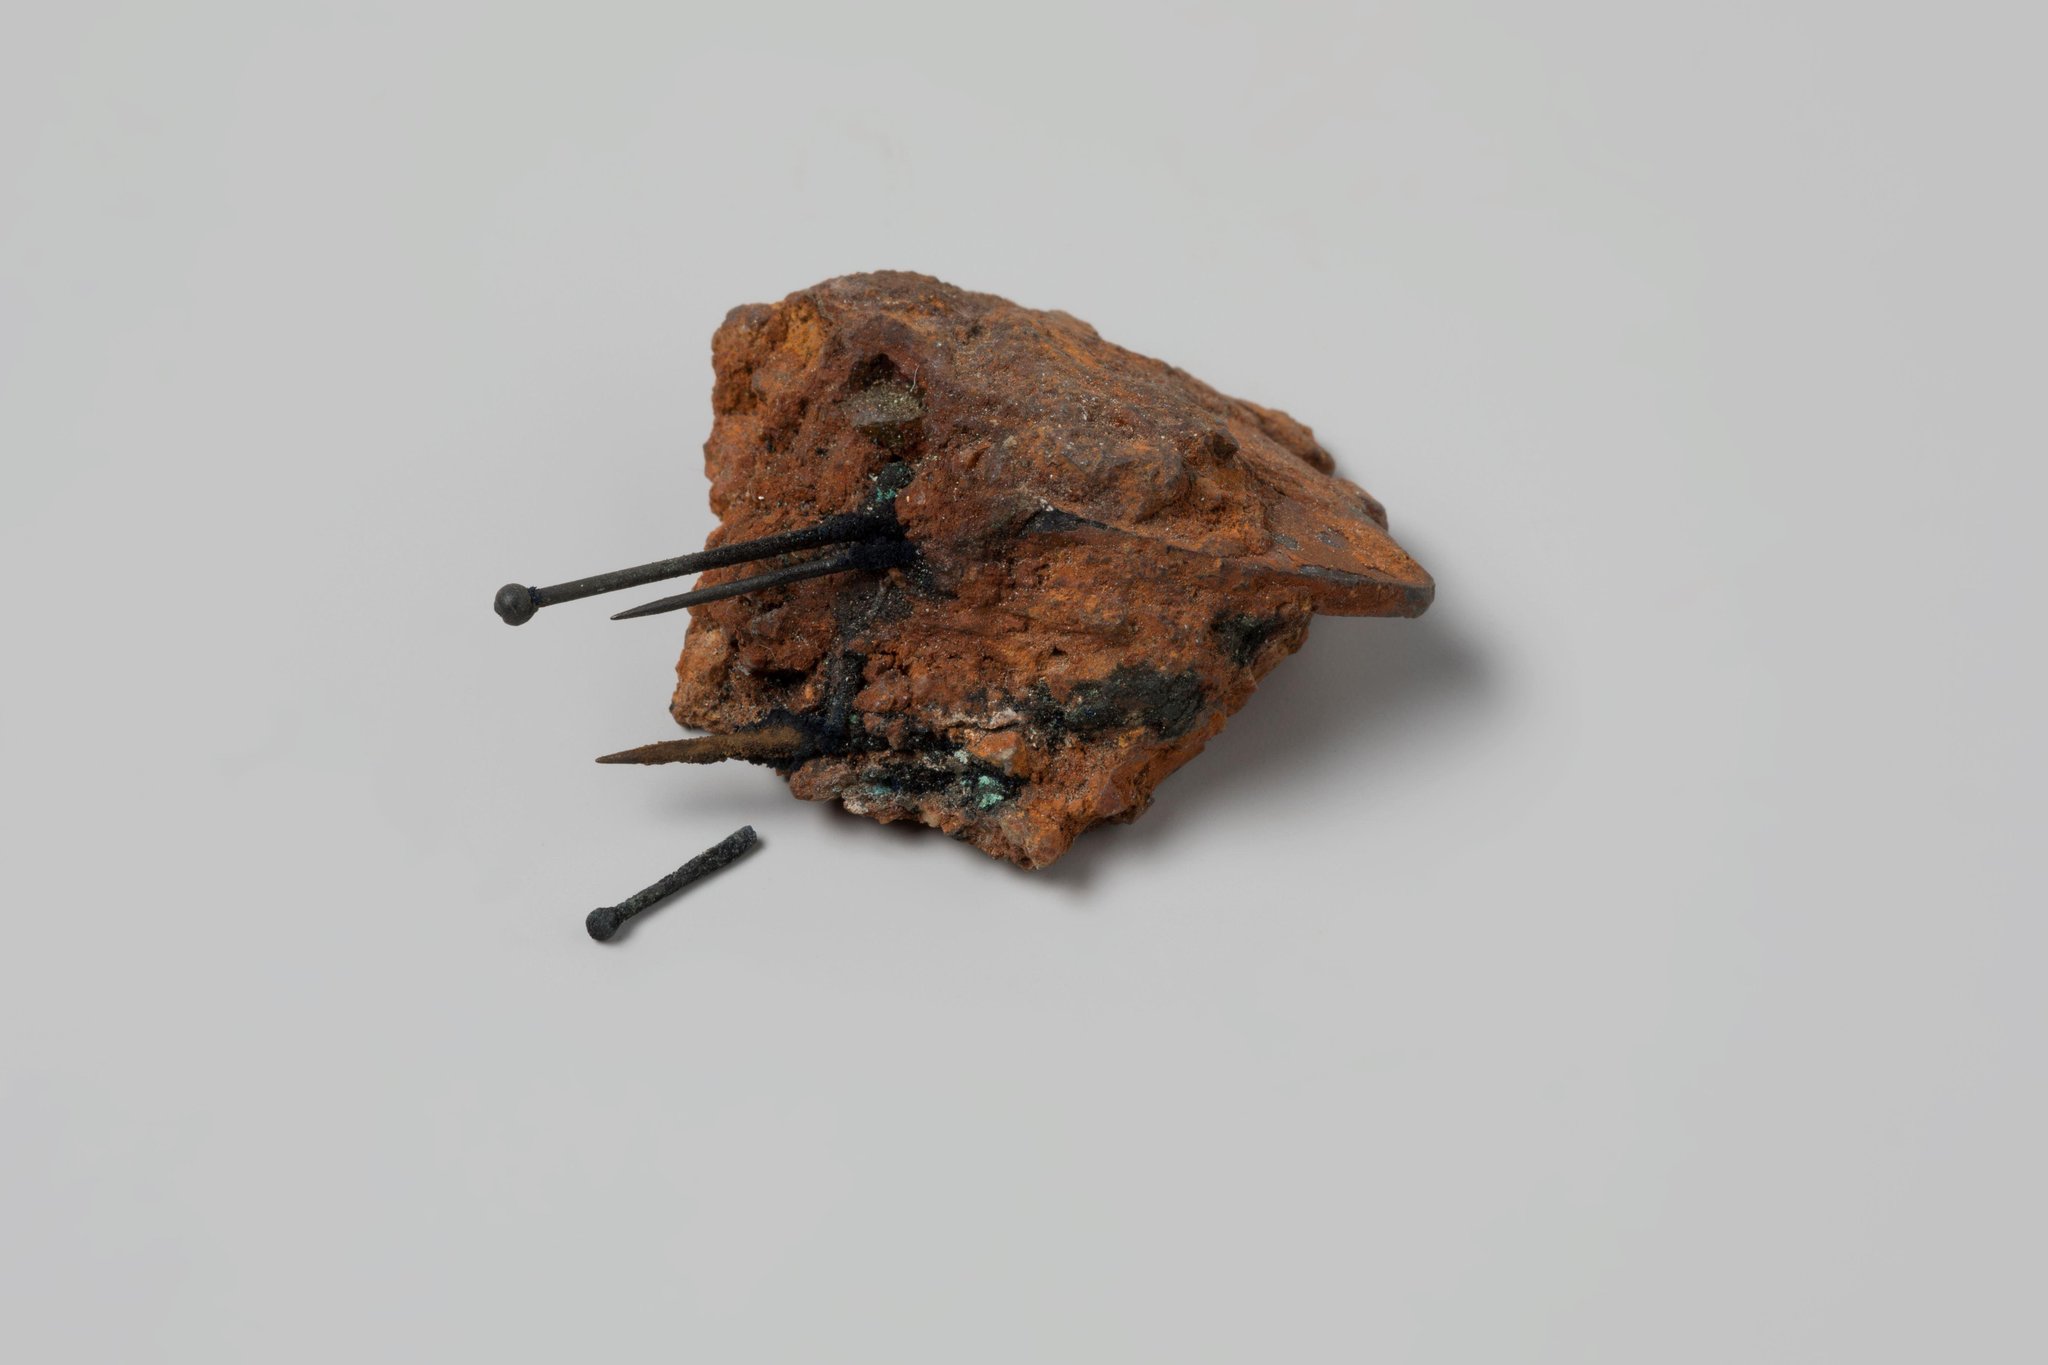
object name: pin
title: Spelden in concretie uit het wrak van de Oost-Indiëvaarder Hollandia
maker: Anonymous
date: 1700-1743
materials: copper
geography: netherlands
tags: verenigde oostindische compagnie, hollandia (schip), annet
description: Pin, tools and instruments, sewing and sailmaking, pin; pointed wire with ball-shaped top, concreted.